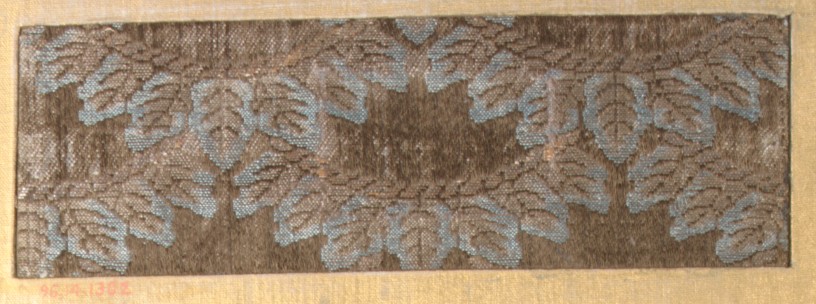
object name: piece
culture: japanese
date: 1701-1900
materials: silk